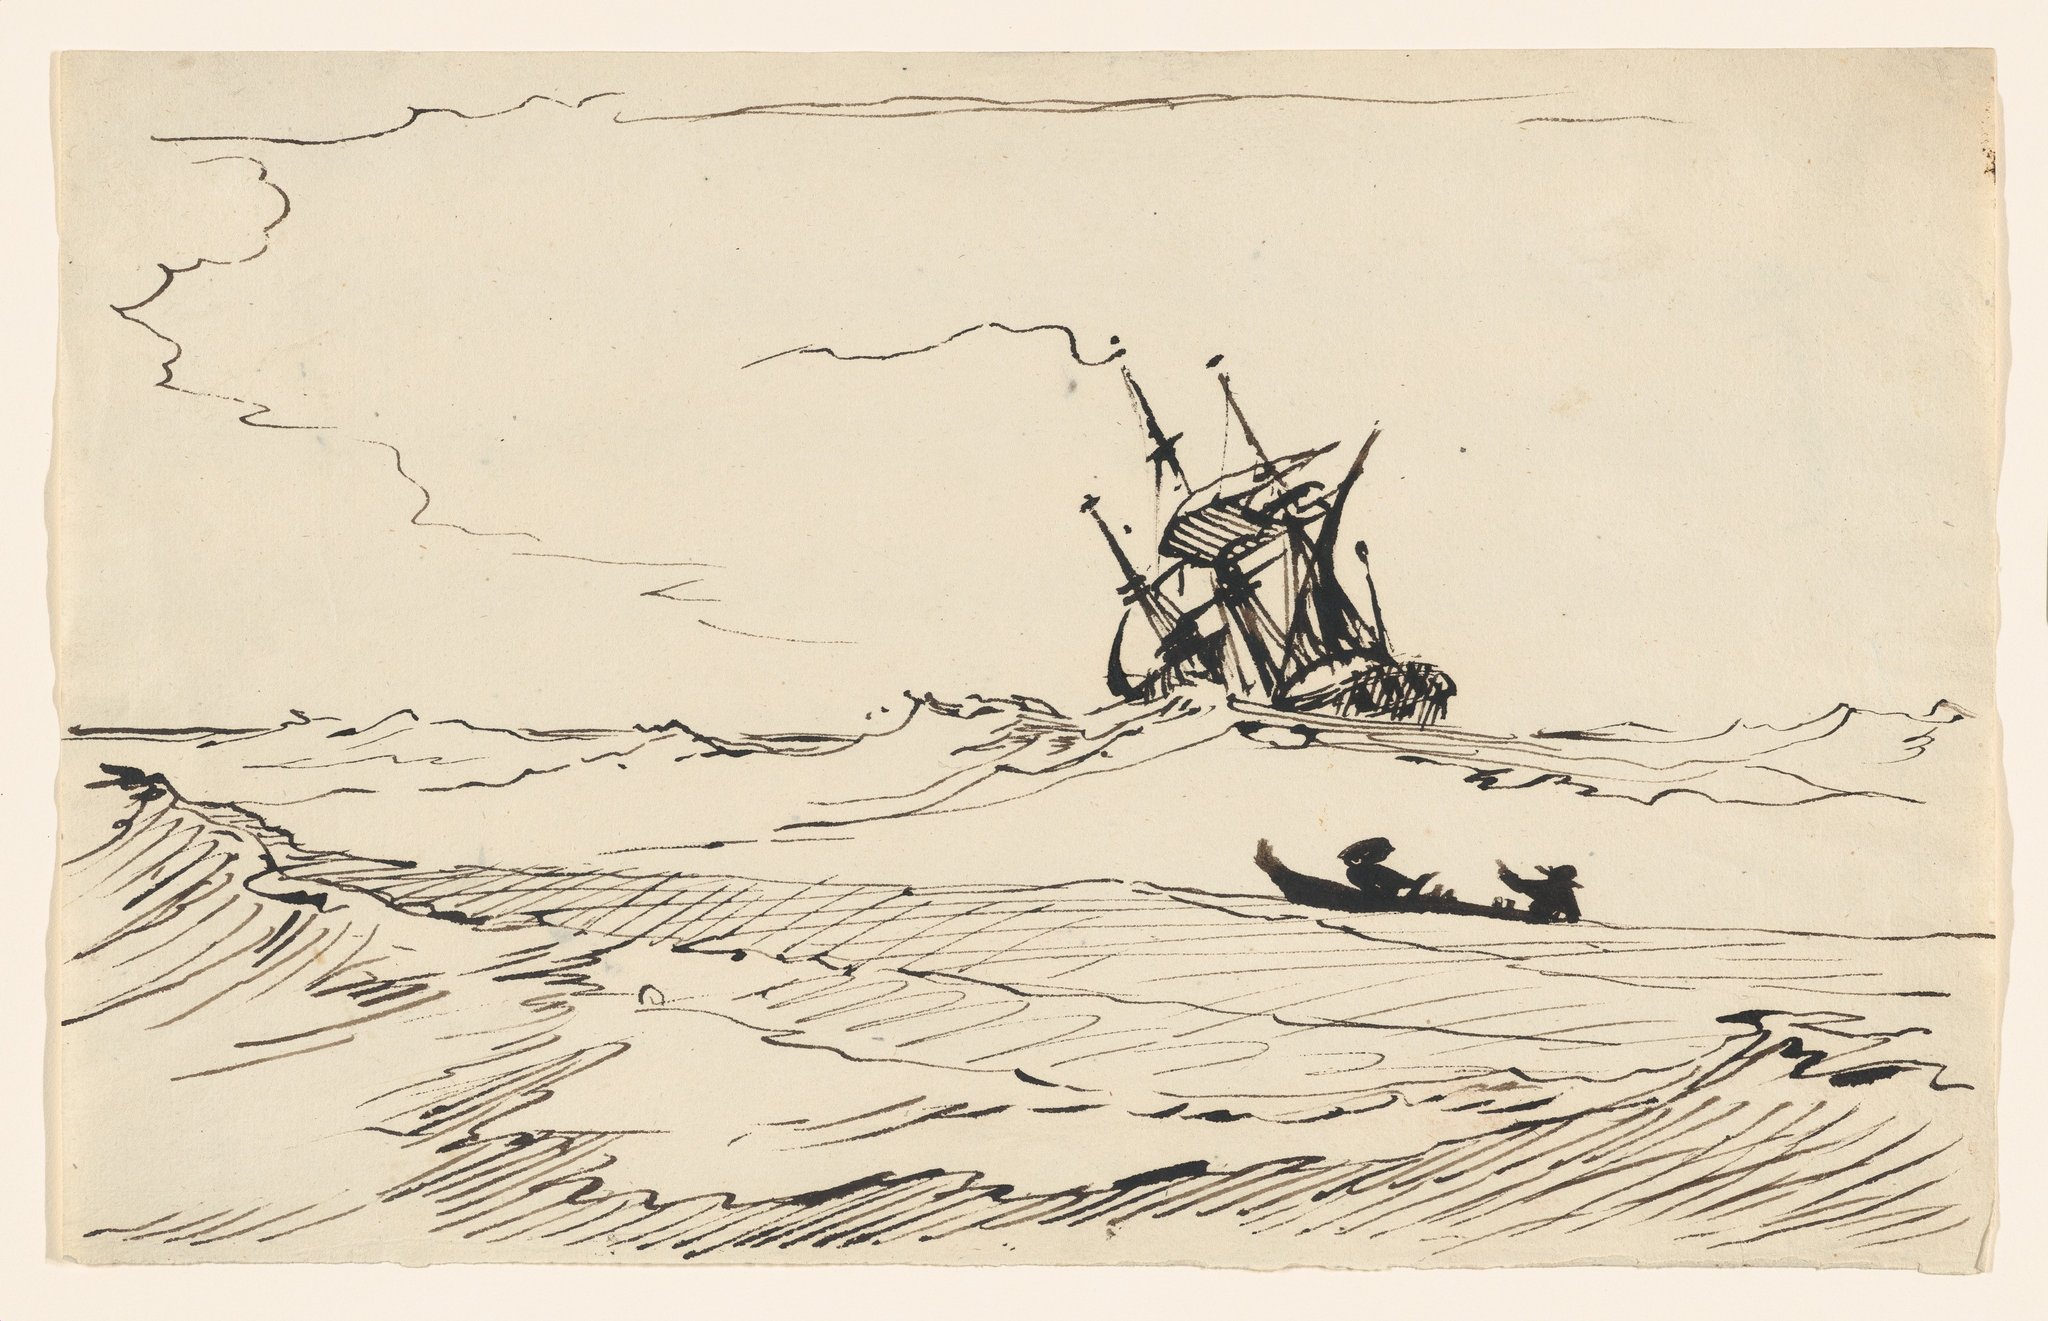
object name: drawing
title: A Storm at Sea with a Large Ship and a Small Boat with Two Figures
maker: carl august ehrensvärd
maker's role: artist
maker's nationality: swedish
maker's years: 1745-1800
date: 1765-1800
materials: ink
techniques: pen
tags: boats,ships